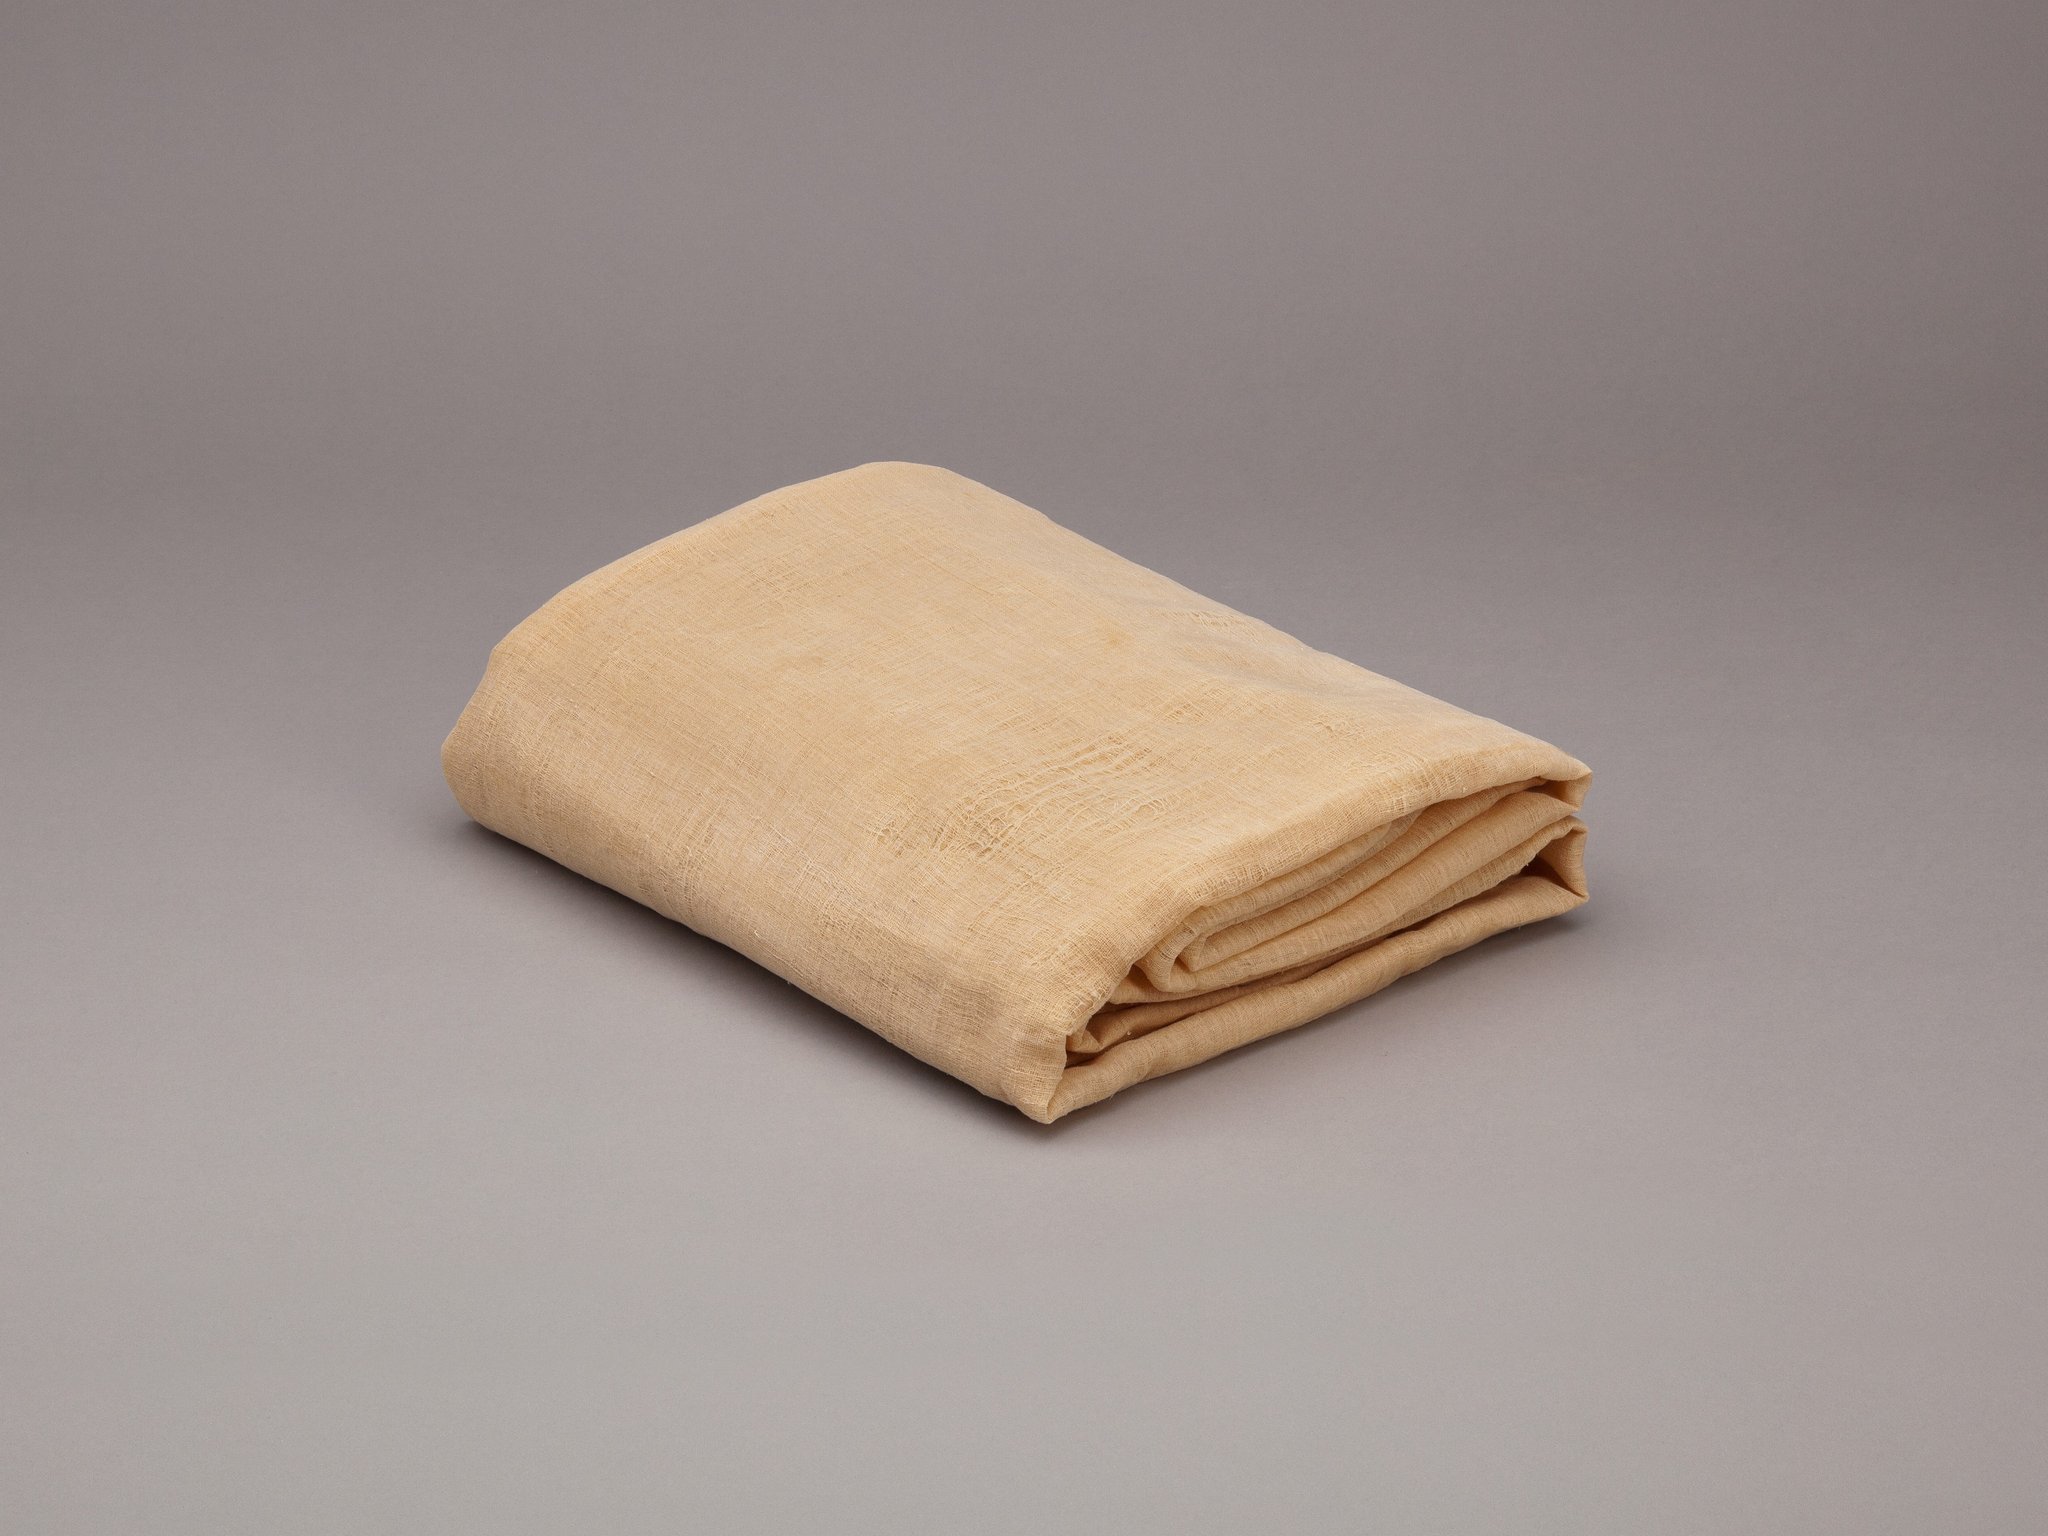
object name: linen mark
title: Sheet, linen mark, fine spin, loose weave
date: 1492-1473 BCE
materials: linen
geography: egypt